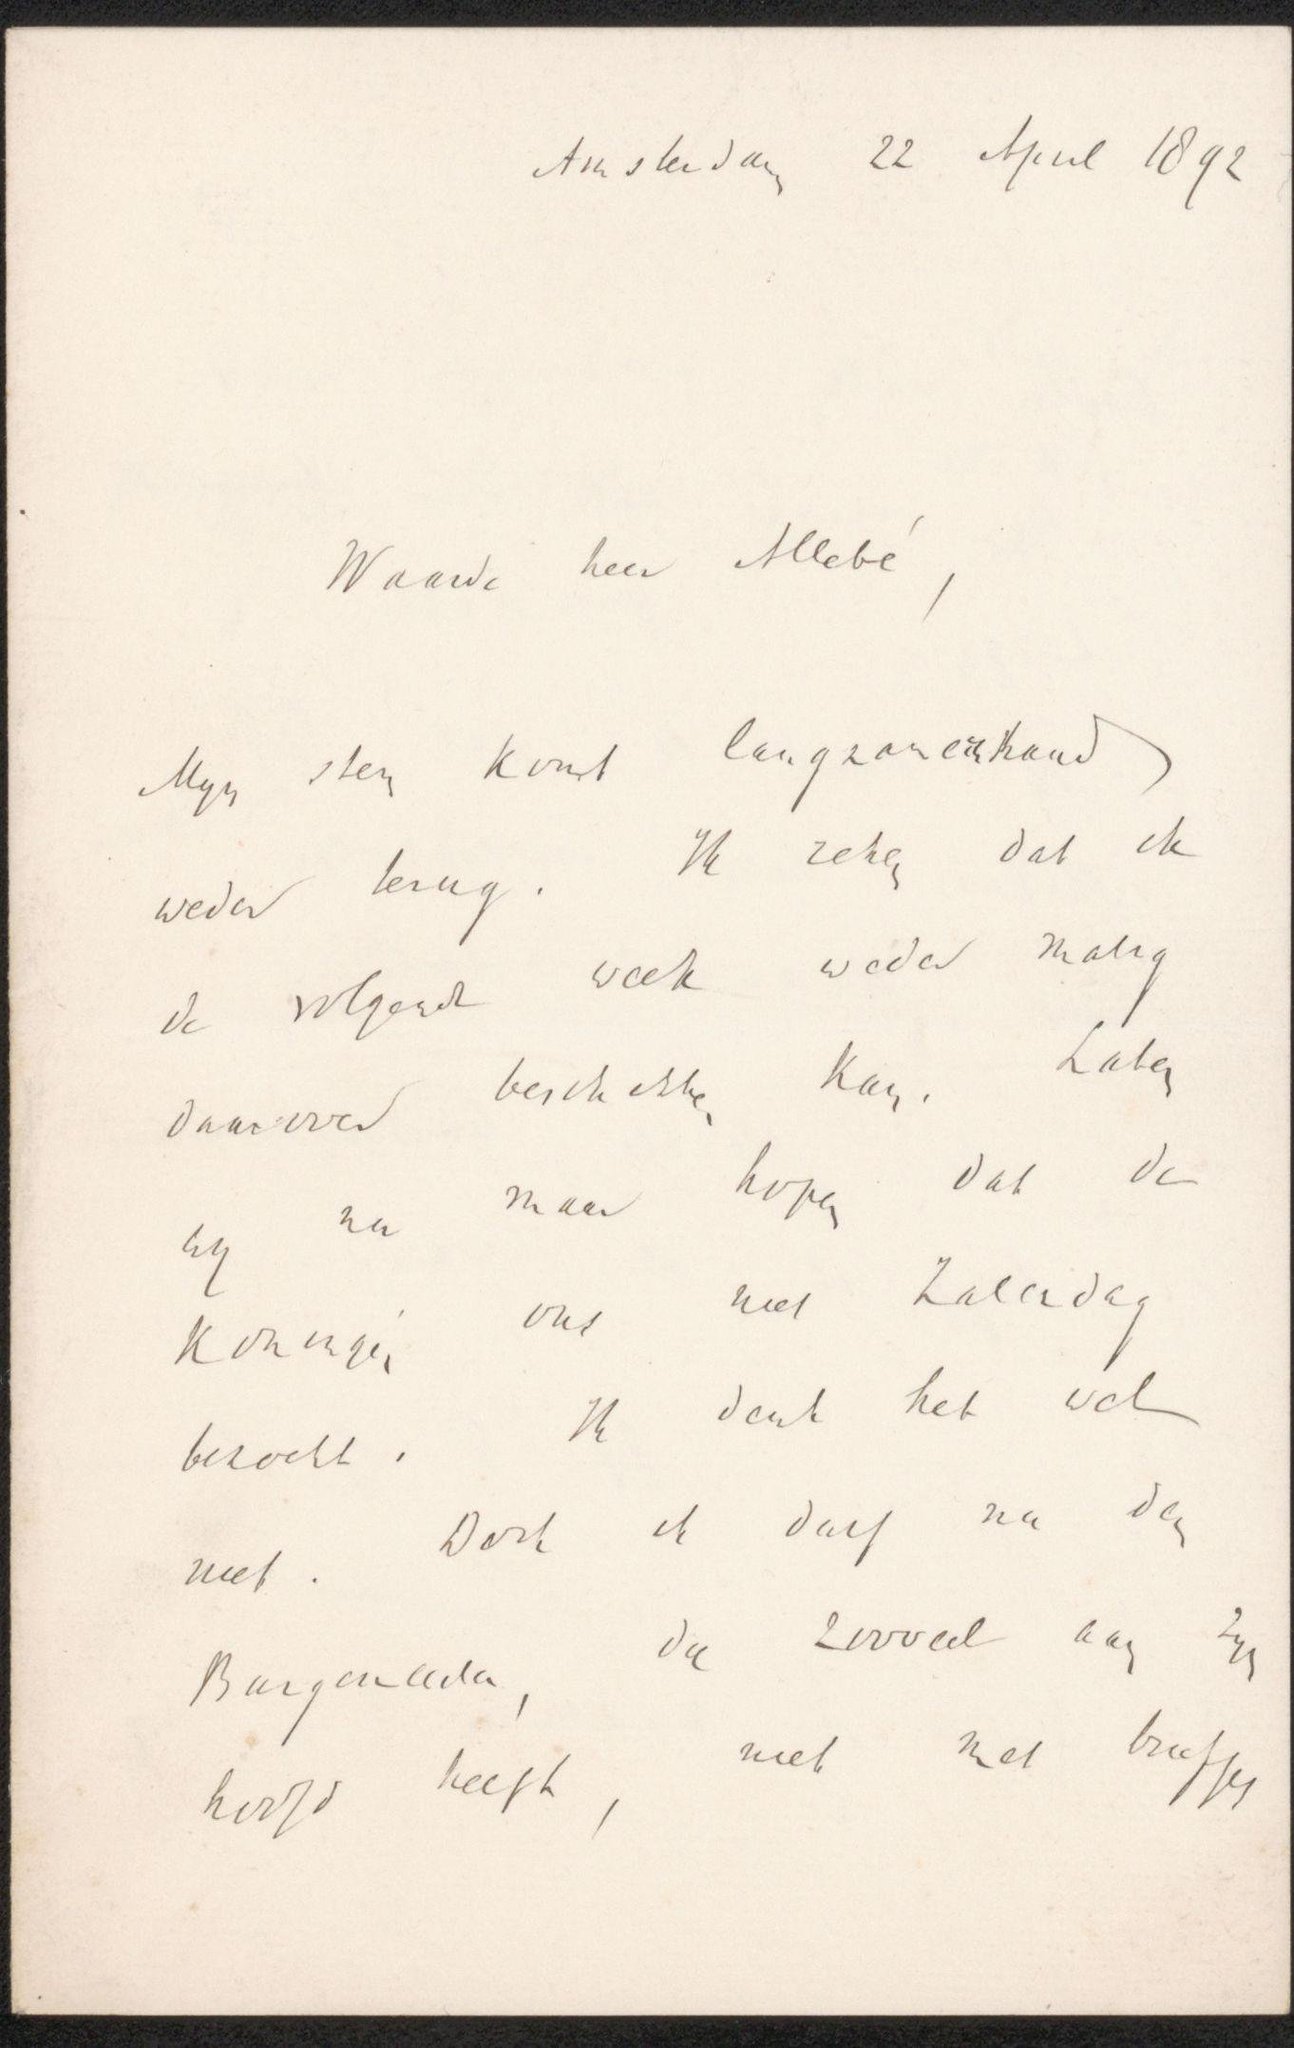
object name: letter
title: Brief aan August Allebé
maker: hendrick peter godfried quack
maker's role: econoom, geschiedschrijver, hoogleraar, jurist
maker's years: 1834-1917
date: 1892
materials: ink, paper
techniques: pen, writing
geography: amsterdam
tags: draughtsman, august allebé, sculpture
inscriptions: watermark